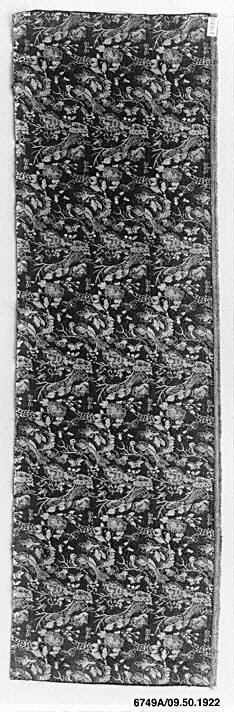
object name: piece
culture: japanese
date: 1801-1900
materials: silk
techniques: brocade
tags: leaves